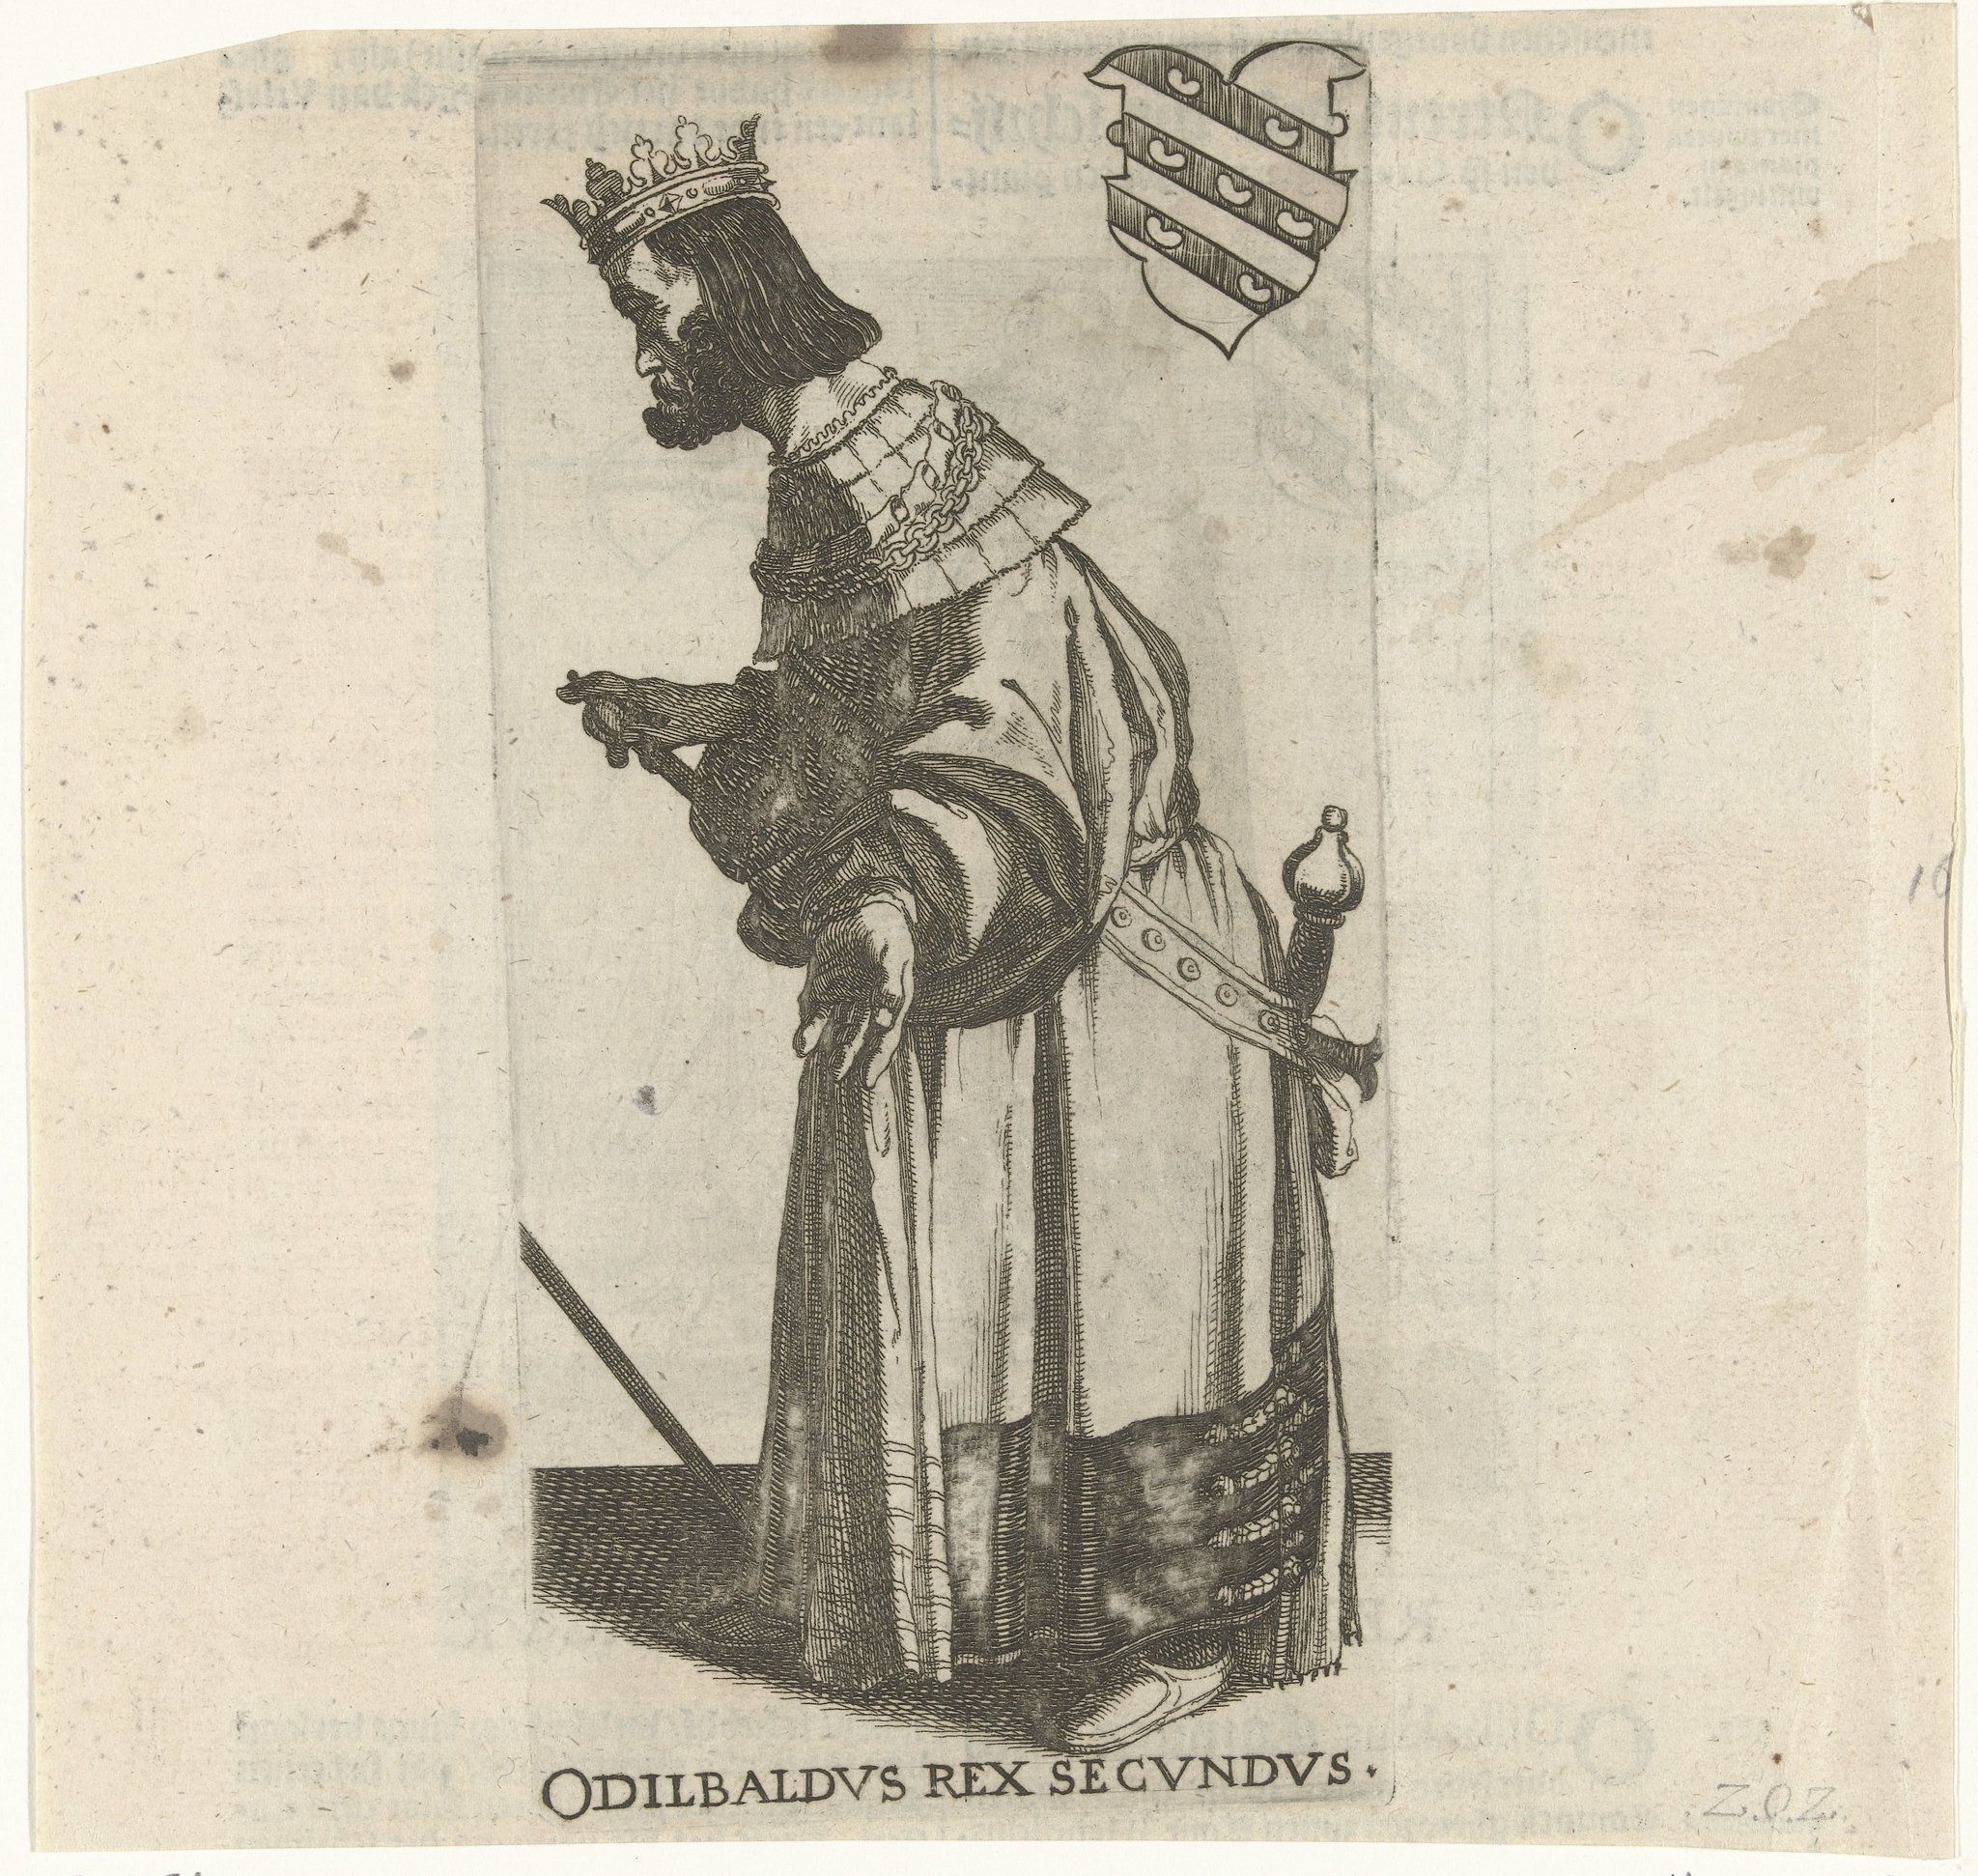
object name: print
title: Odilbaldus rex secundus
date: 1622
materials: paper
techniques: etching, letterpress printing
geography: franeker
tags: koning, odilbald (koning der friezen)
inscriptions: collector's mark: Lugt 2228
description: De prent is ook als boekillustratie gebruikt in: Winsemius, P.W. Chronique ofte Historische geschiedenisse van Vrieslant (...). Franeker: Joannes Lamrinck, 1622.